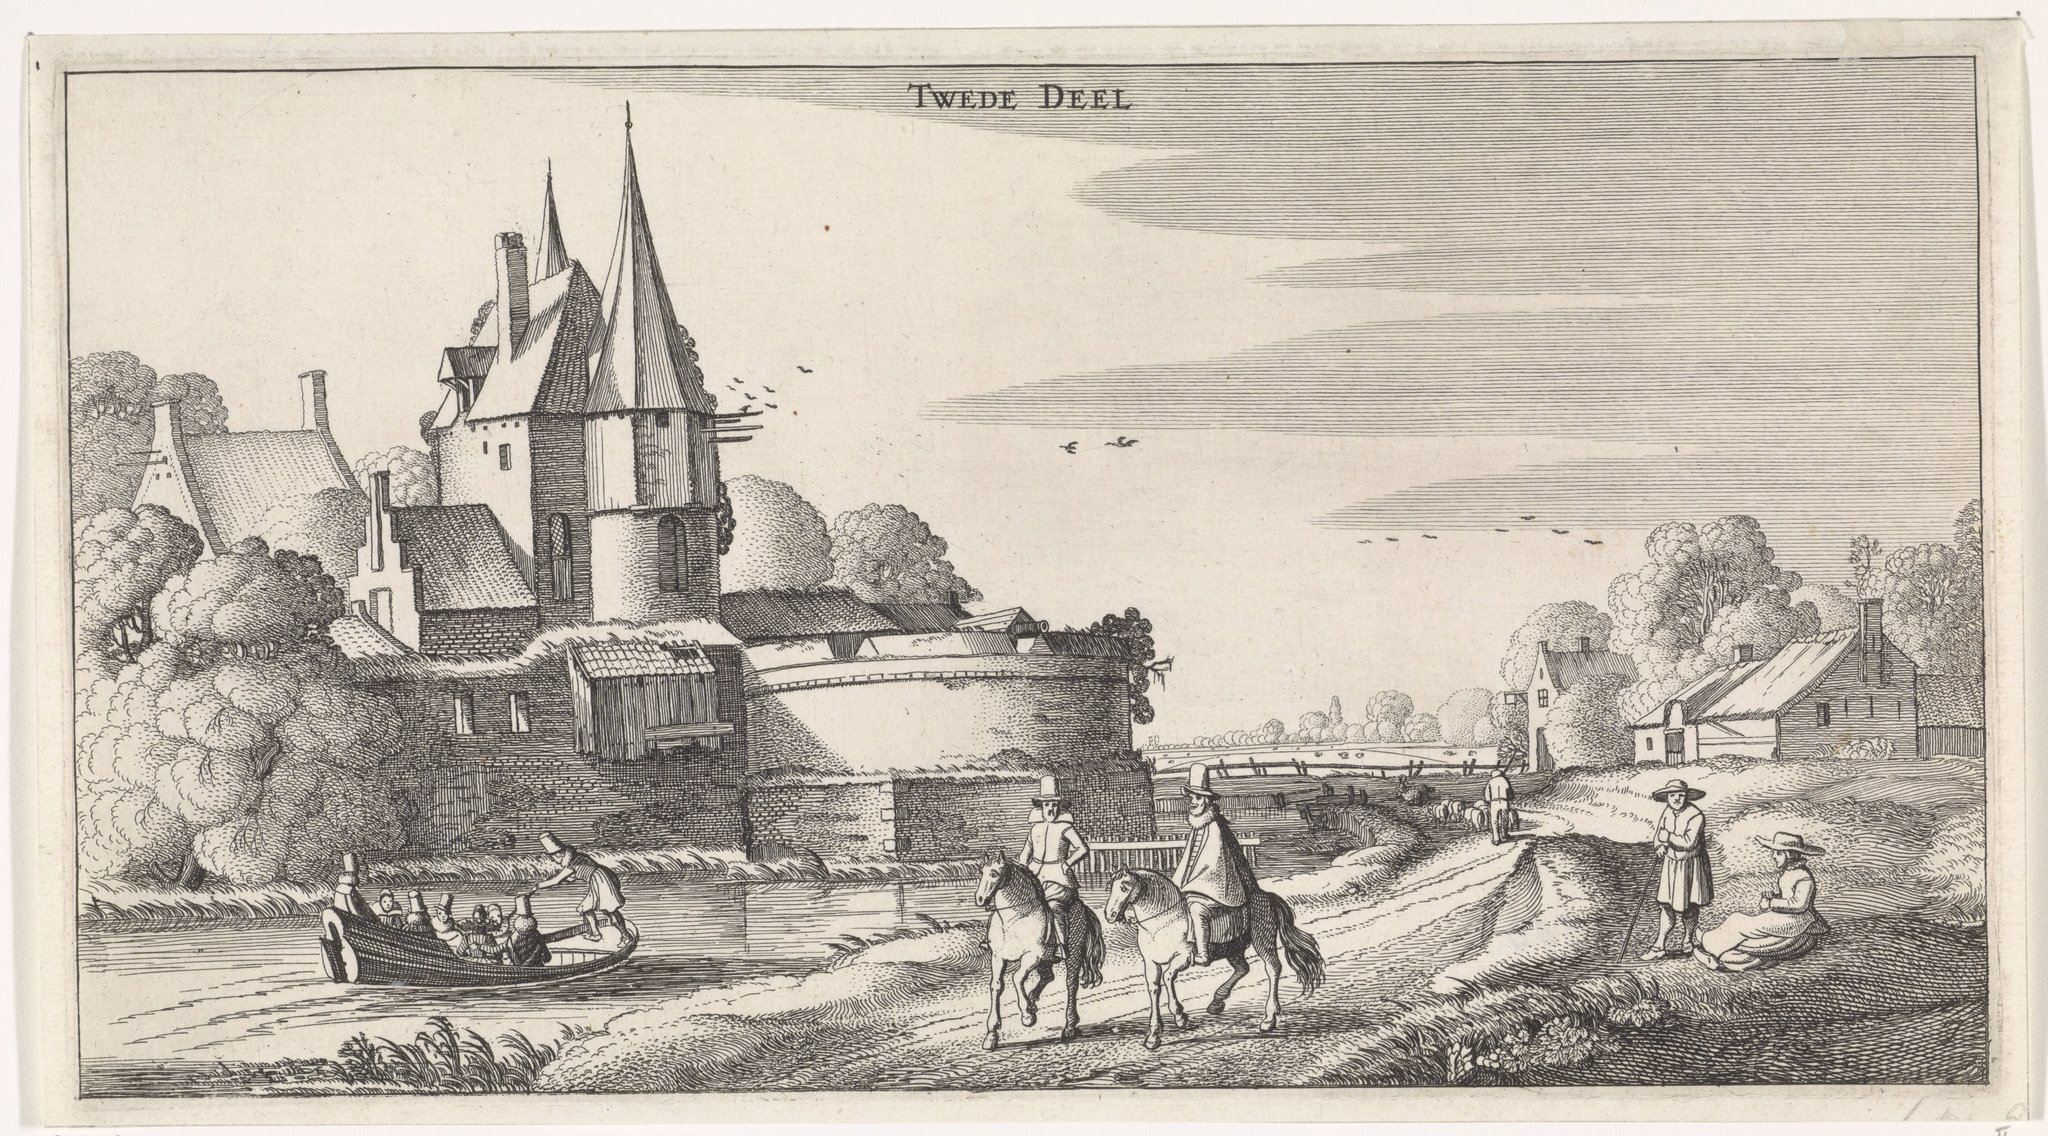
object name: print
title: Figuren bij een kasteel in een rivierlandschap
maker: jan van de velde (ii)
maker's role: draughtsman, painter, print maker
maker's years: 1593-1641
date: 1639-1641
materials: paper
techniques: etching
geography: northern netherlands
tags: riding a horse, ass, or mule; rider, horseman, river, landscape with tower or castle, bastion, bulwark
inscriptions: collector's mark: Lugt 964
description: Twee ruiters op een pad langs een rivier bij een kasteel. Op het water een boot met een elegant gezelschap. Zevende prent van een serie met 36 prenten van landschappen, verdeeld over zes delen.